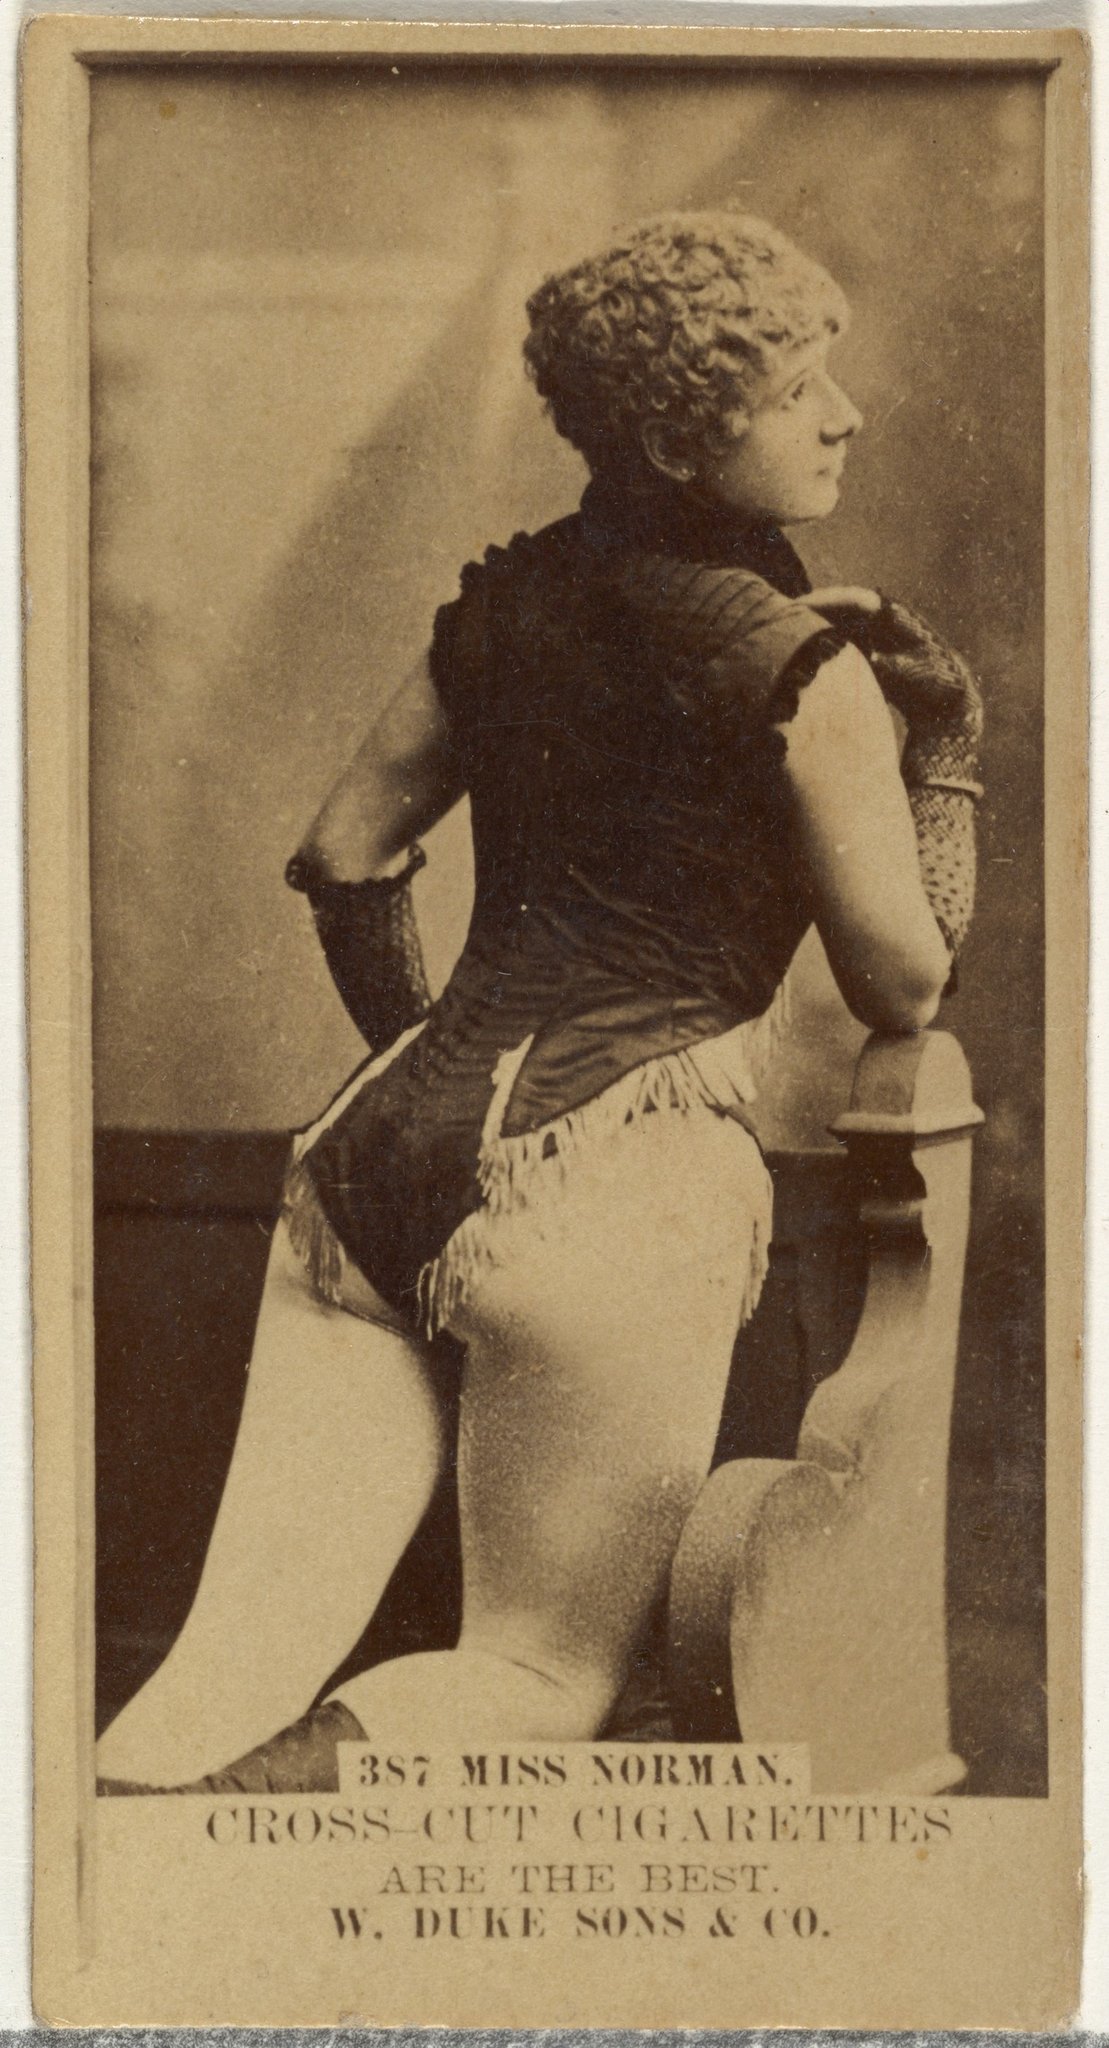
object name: photograph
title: Card Number 387, Miss Norman, from the Actors and Actresses series (N145-3) issued by Duke Sons & Co. to promote Cross Cut Cigarettes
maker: w. duke, sons & co.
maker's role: publisher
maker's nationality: american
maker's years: 1870-1920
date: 1880-1889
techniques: albumen silver print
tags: women,actresses